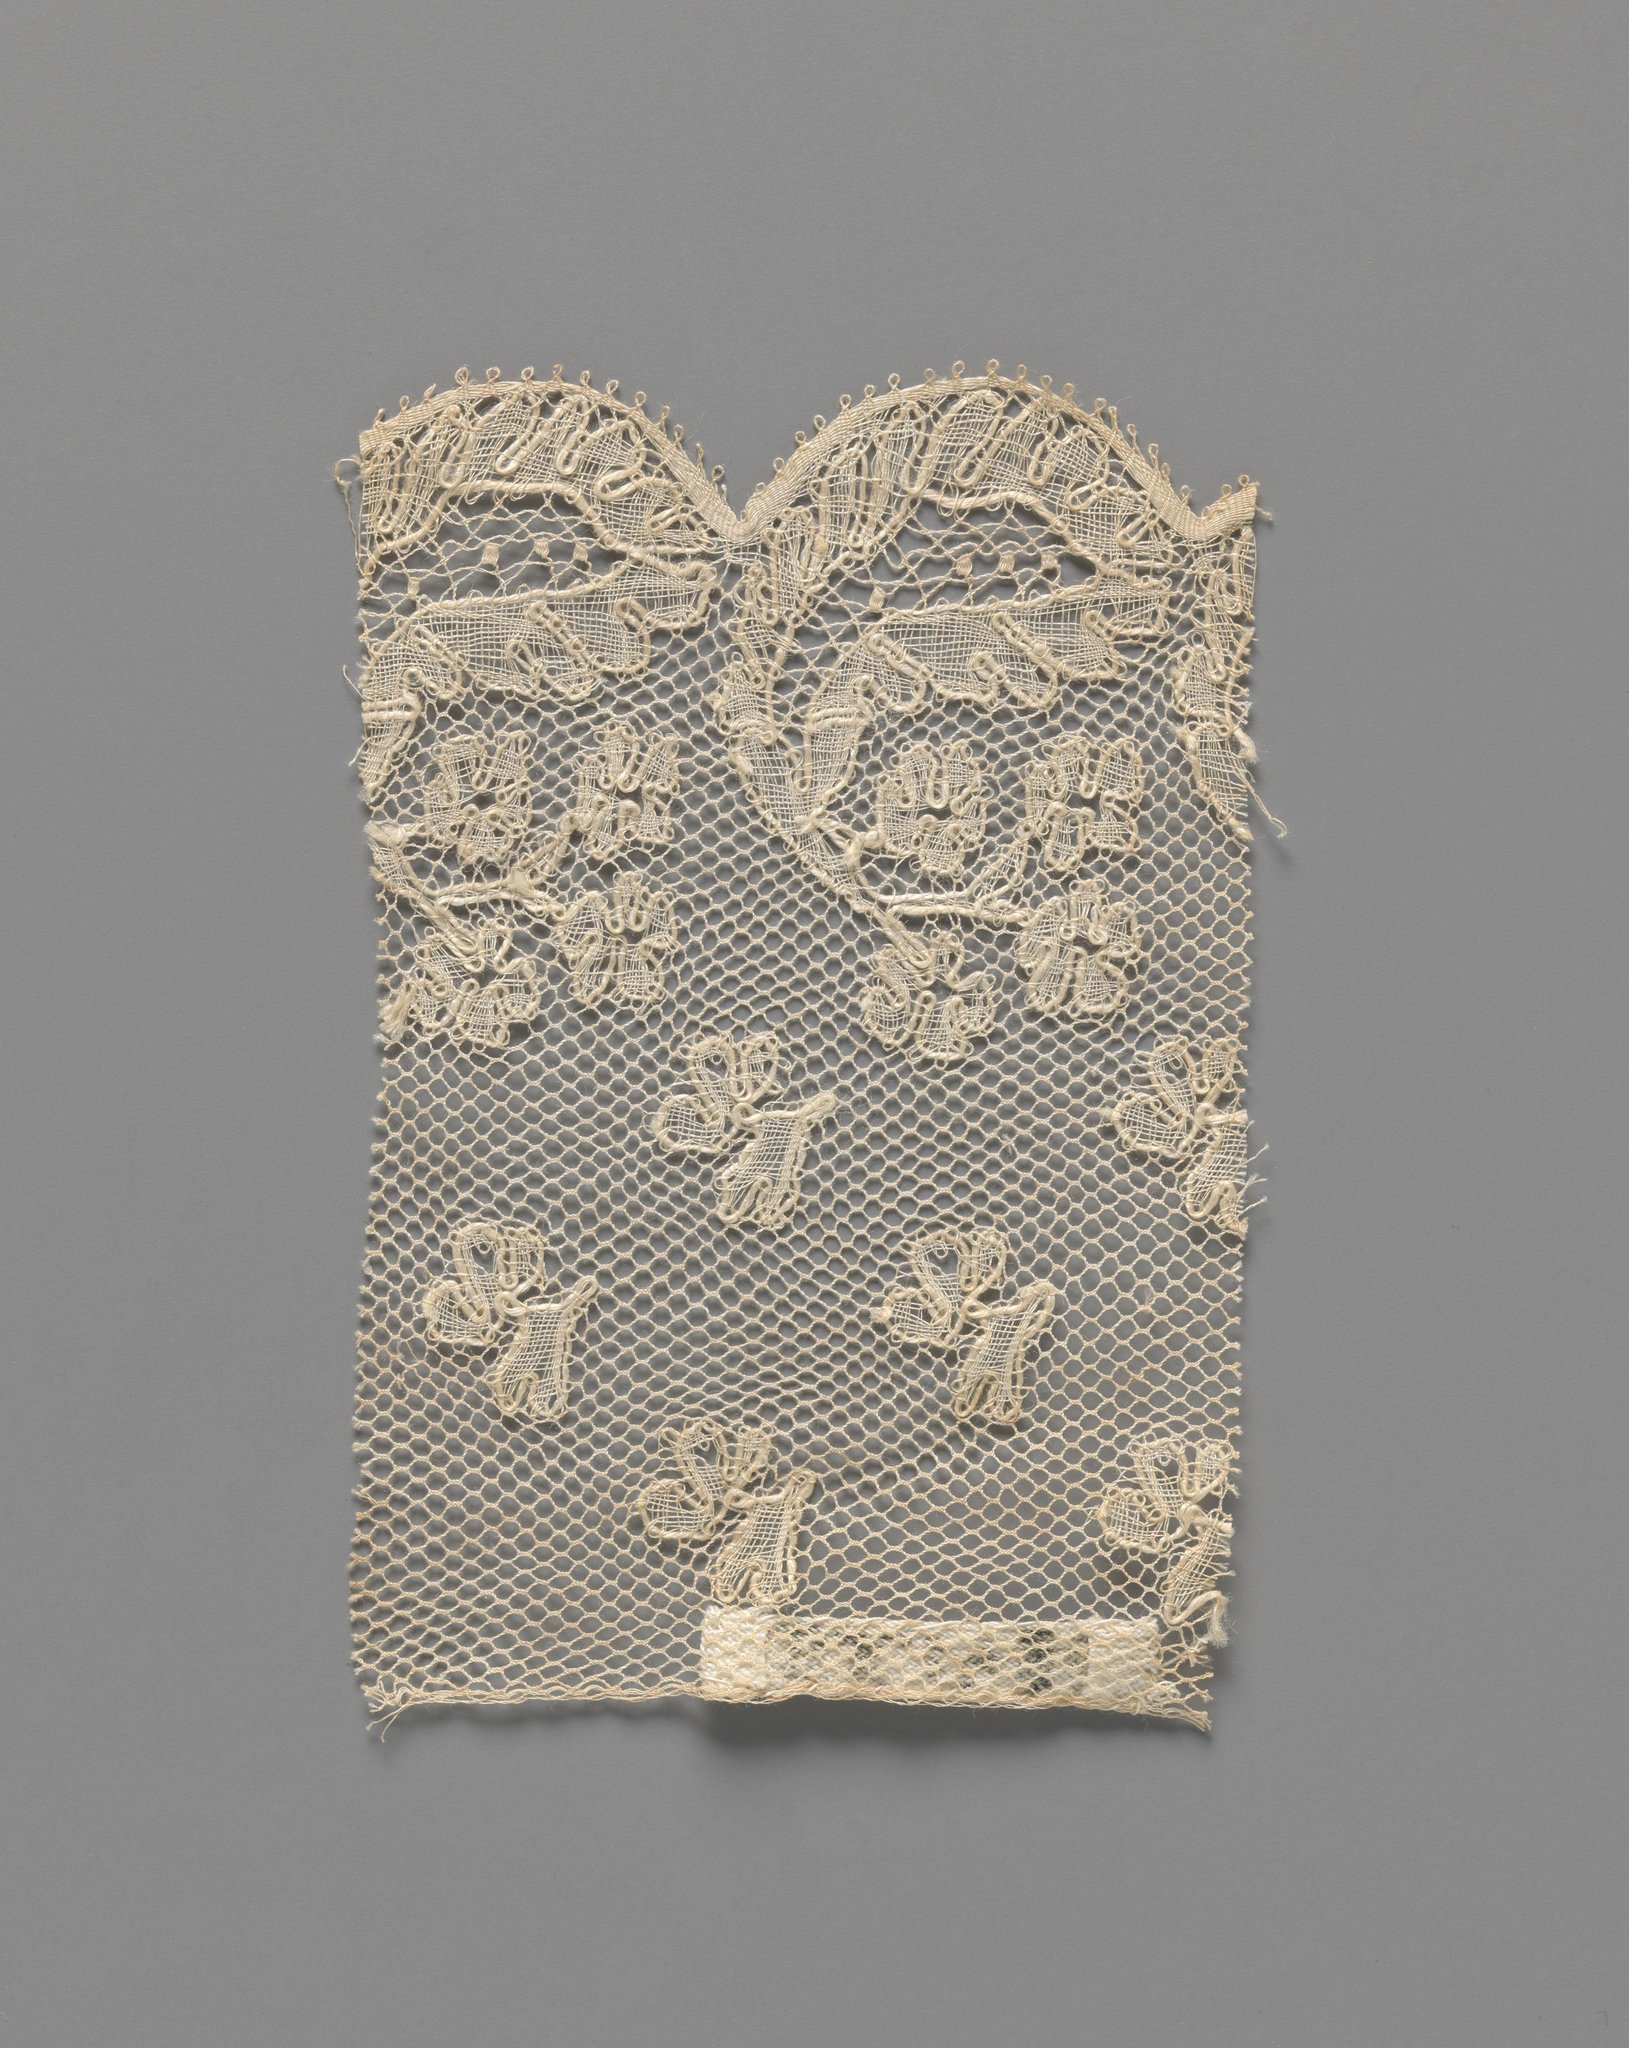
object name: sample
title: Staal kloskant met Mechelse grond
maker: Anonymous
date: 1875-1899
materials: cotton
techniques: lace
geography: turnhout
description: Staal of kort stuk van een strook naturelkleurige kloskant: Mechelse kloskant. Afkomstig van een opgeheven kantschool te Turnhout.